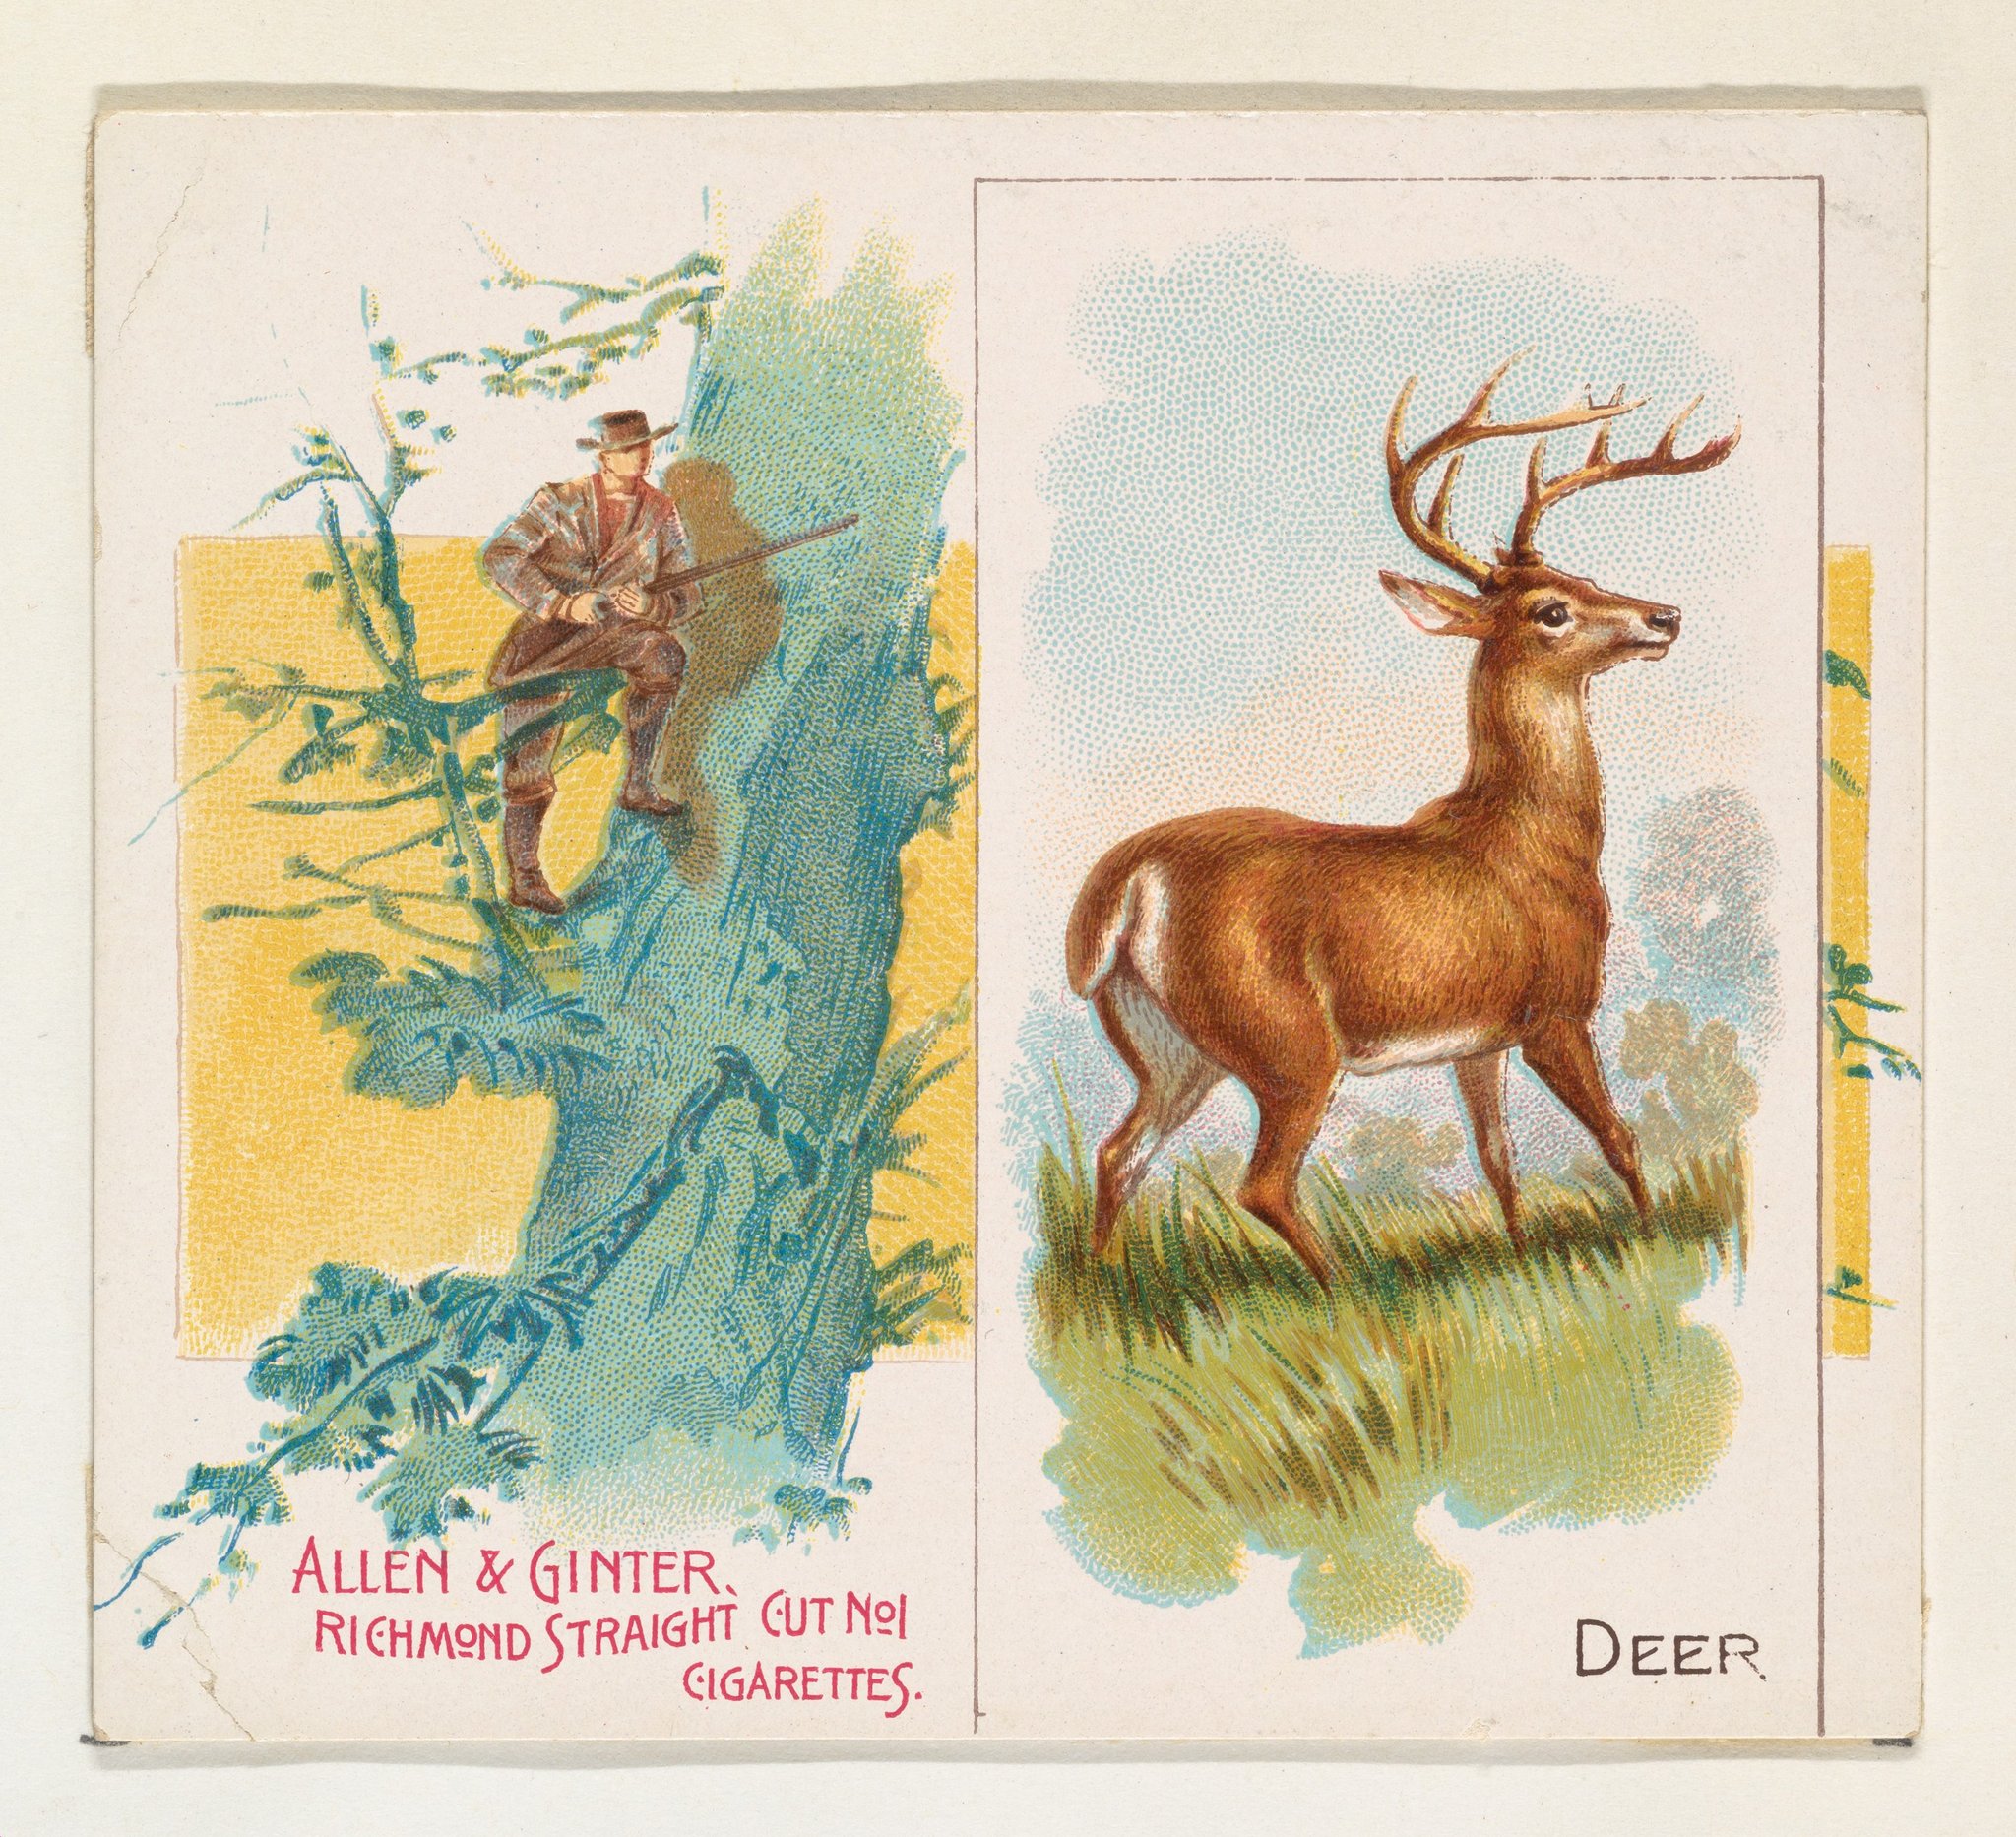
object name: print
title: Deer, from Quadrupeds series (N41) for Allen & Ginter Cigarettes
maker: allen & ginter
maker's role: publisher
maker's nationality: american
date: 1890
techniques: color lithograph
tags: men,hunting,deer